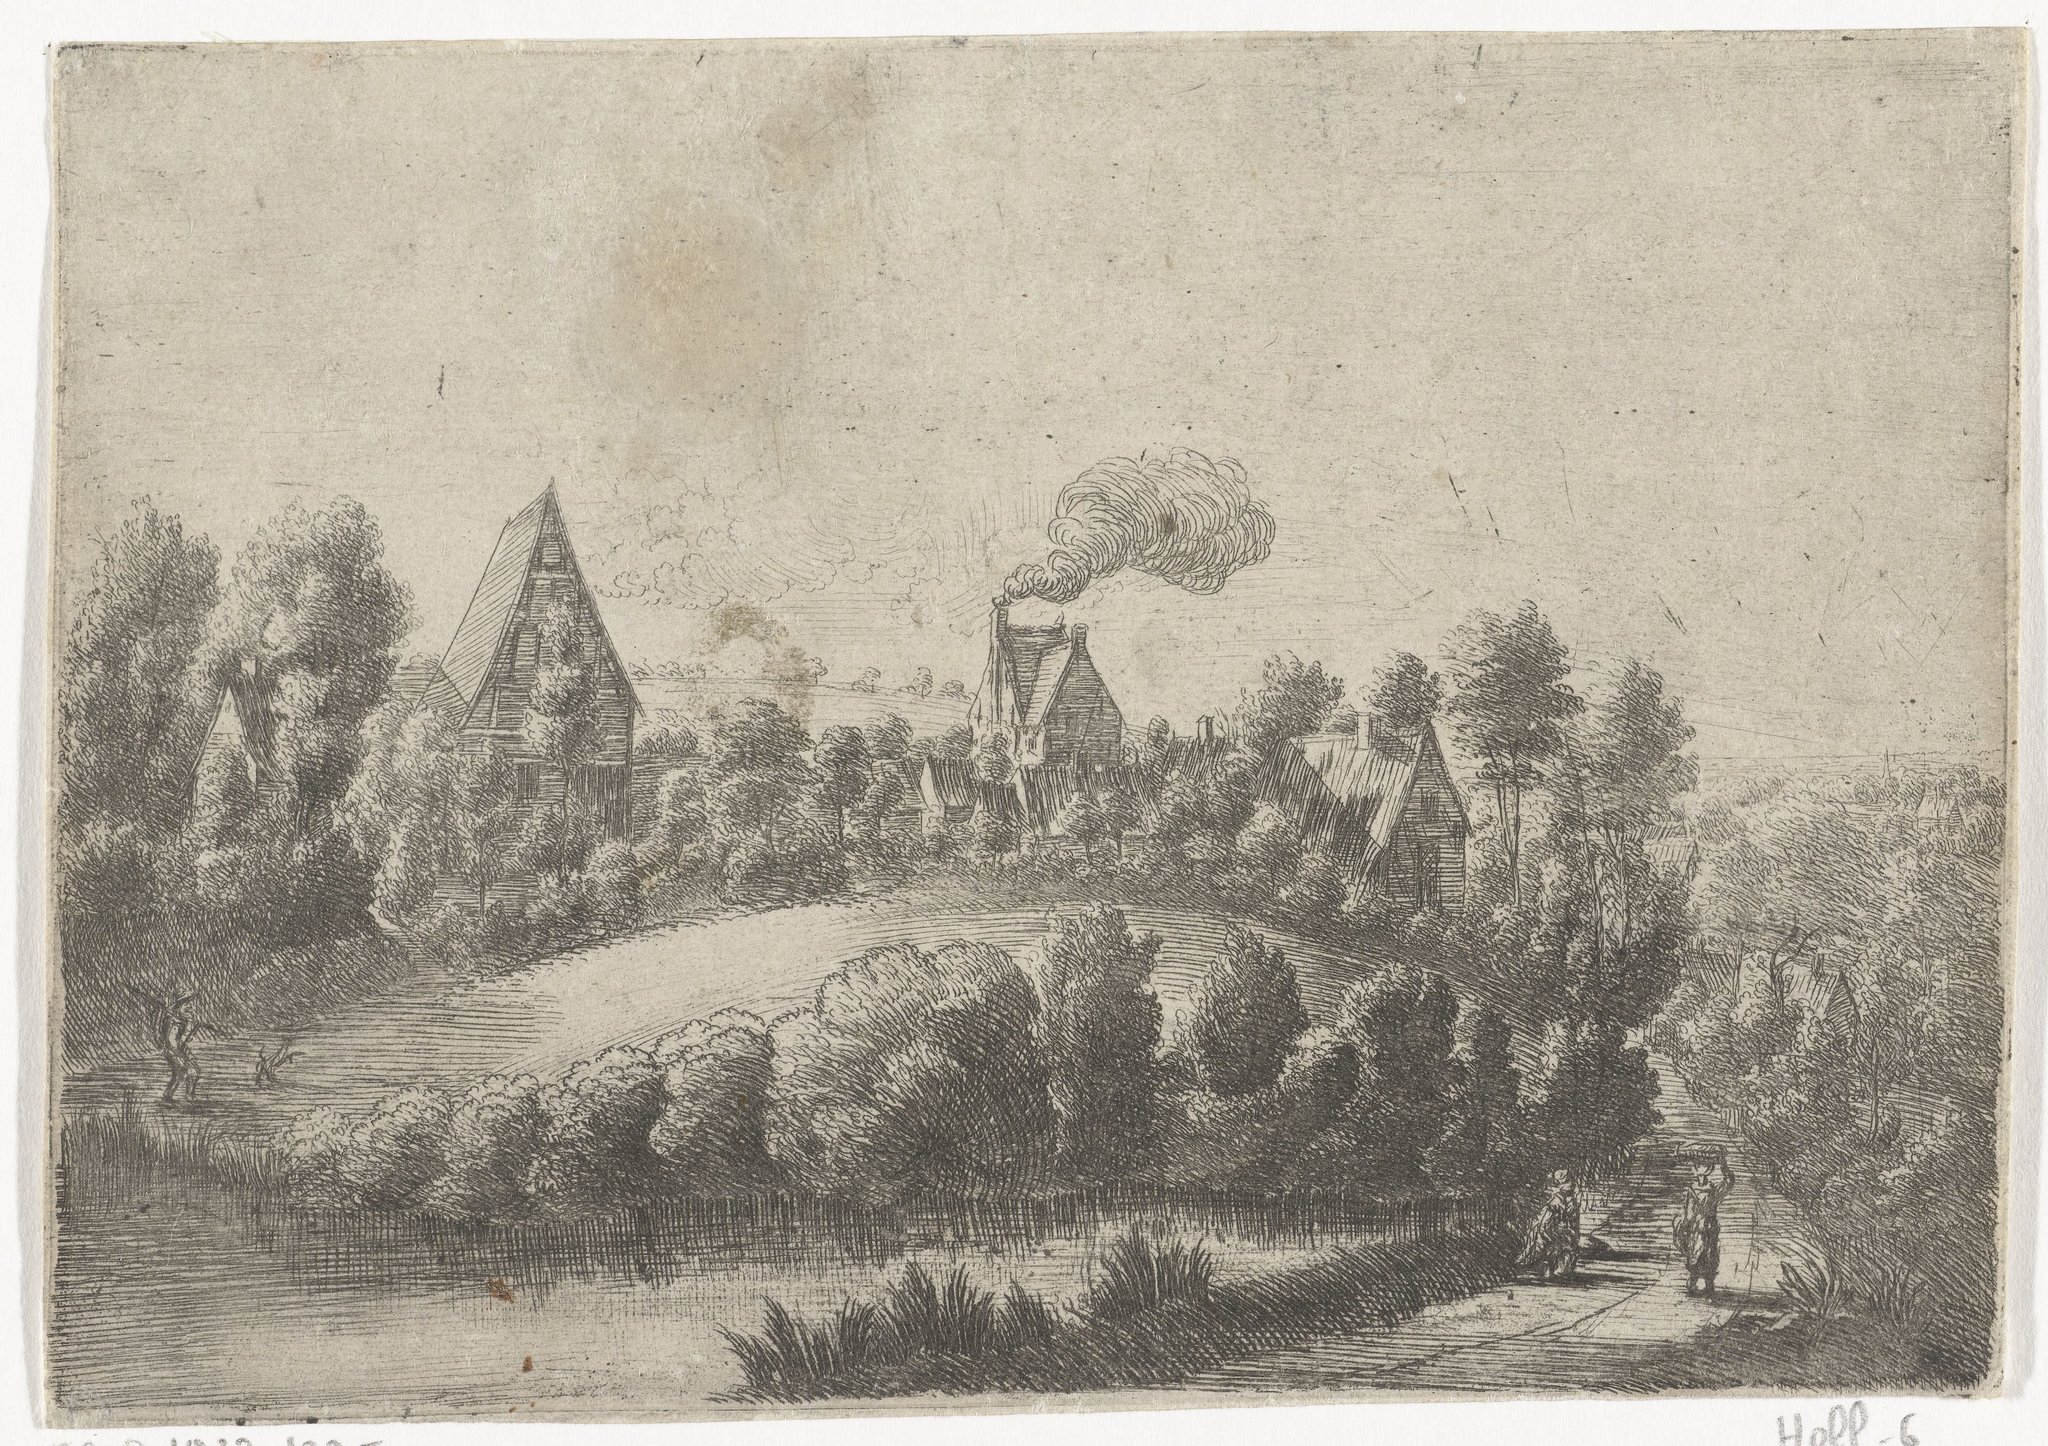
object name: print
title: Landschap met enkele huizen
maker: jean baptiste bonnecroy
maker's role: print maker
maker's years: 1618-1676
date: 1628-1676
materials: paper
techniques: etching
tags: low hill country, dog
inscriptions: collector's mark: Lugt 2760, collector's mark: Lugt 514, collector's mark: Lugt 2228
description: Een heuvellandschap met enkele huizen op de achtergrond. Rechts een zandweg met twee wandelaars. Links een man en zijn hond.